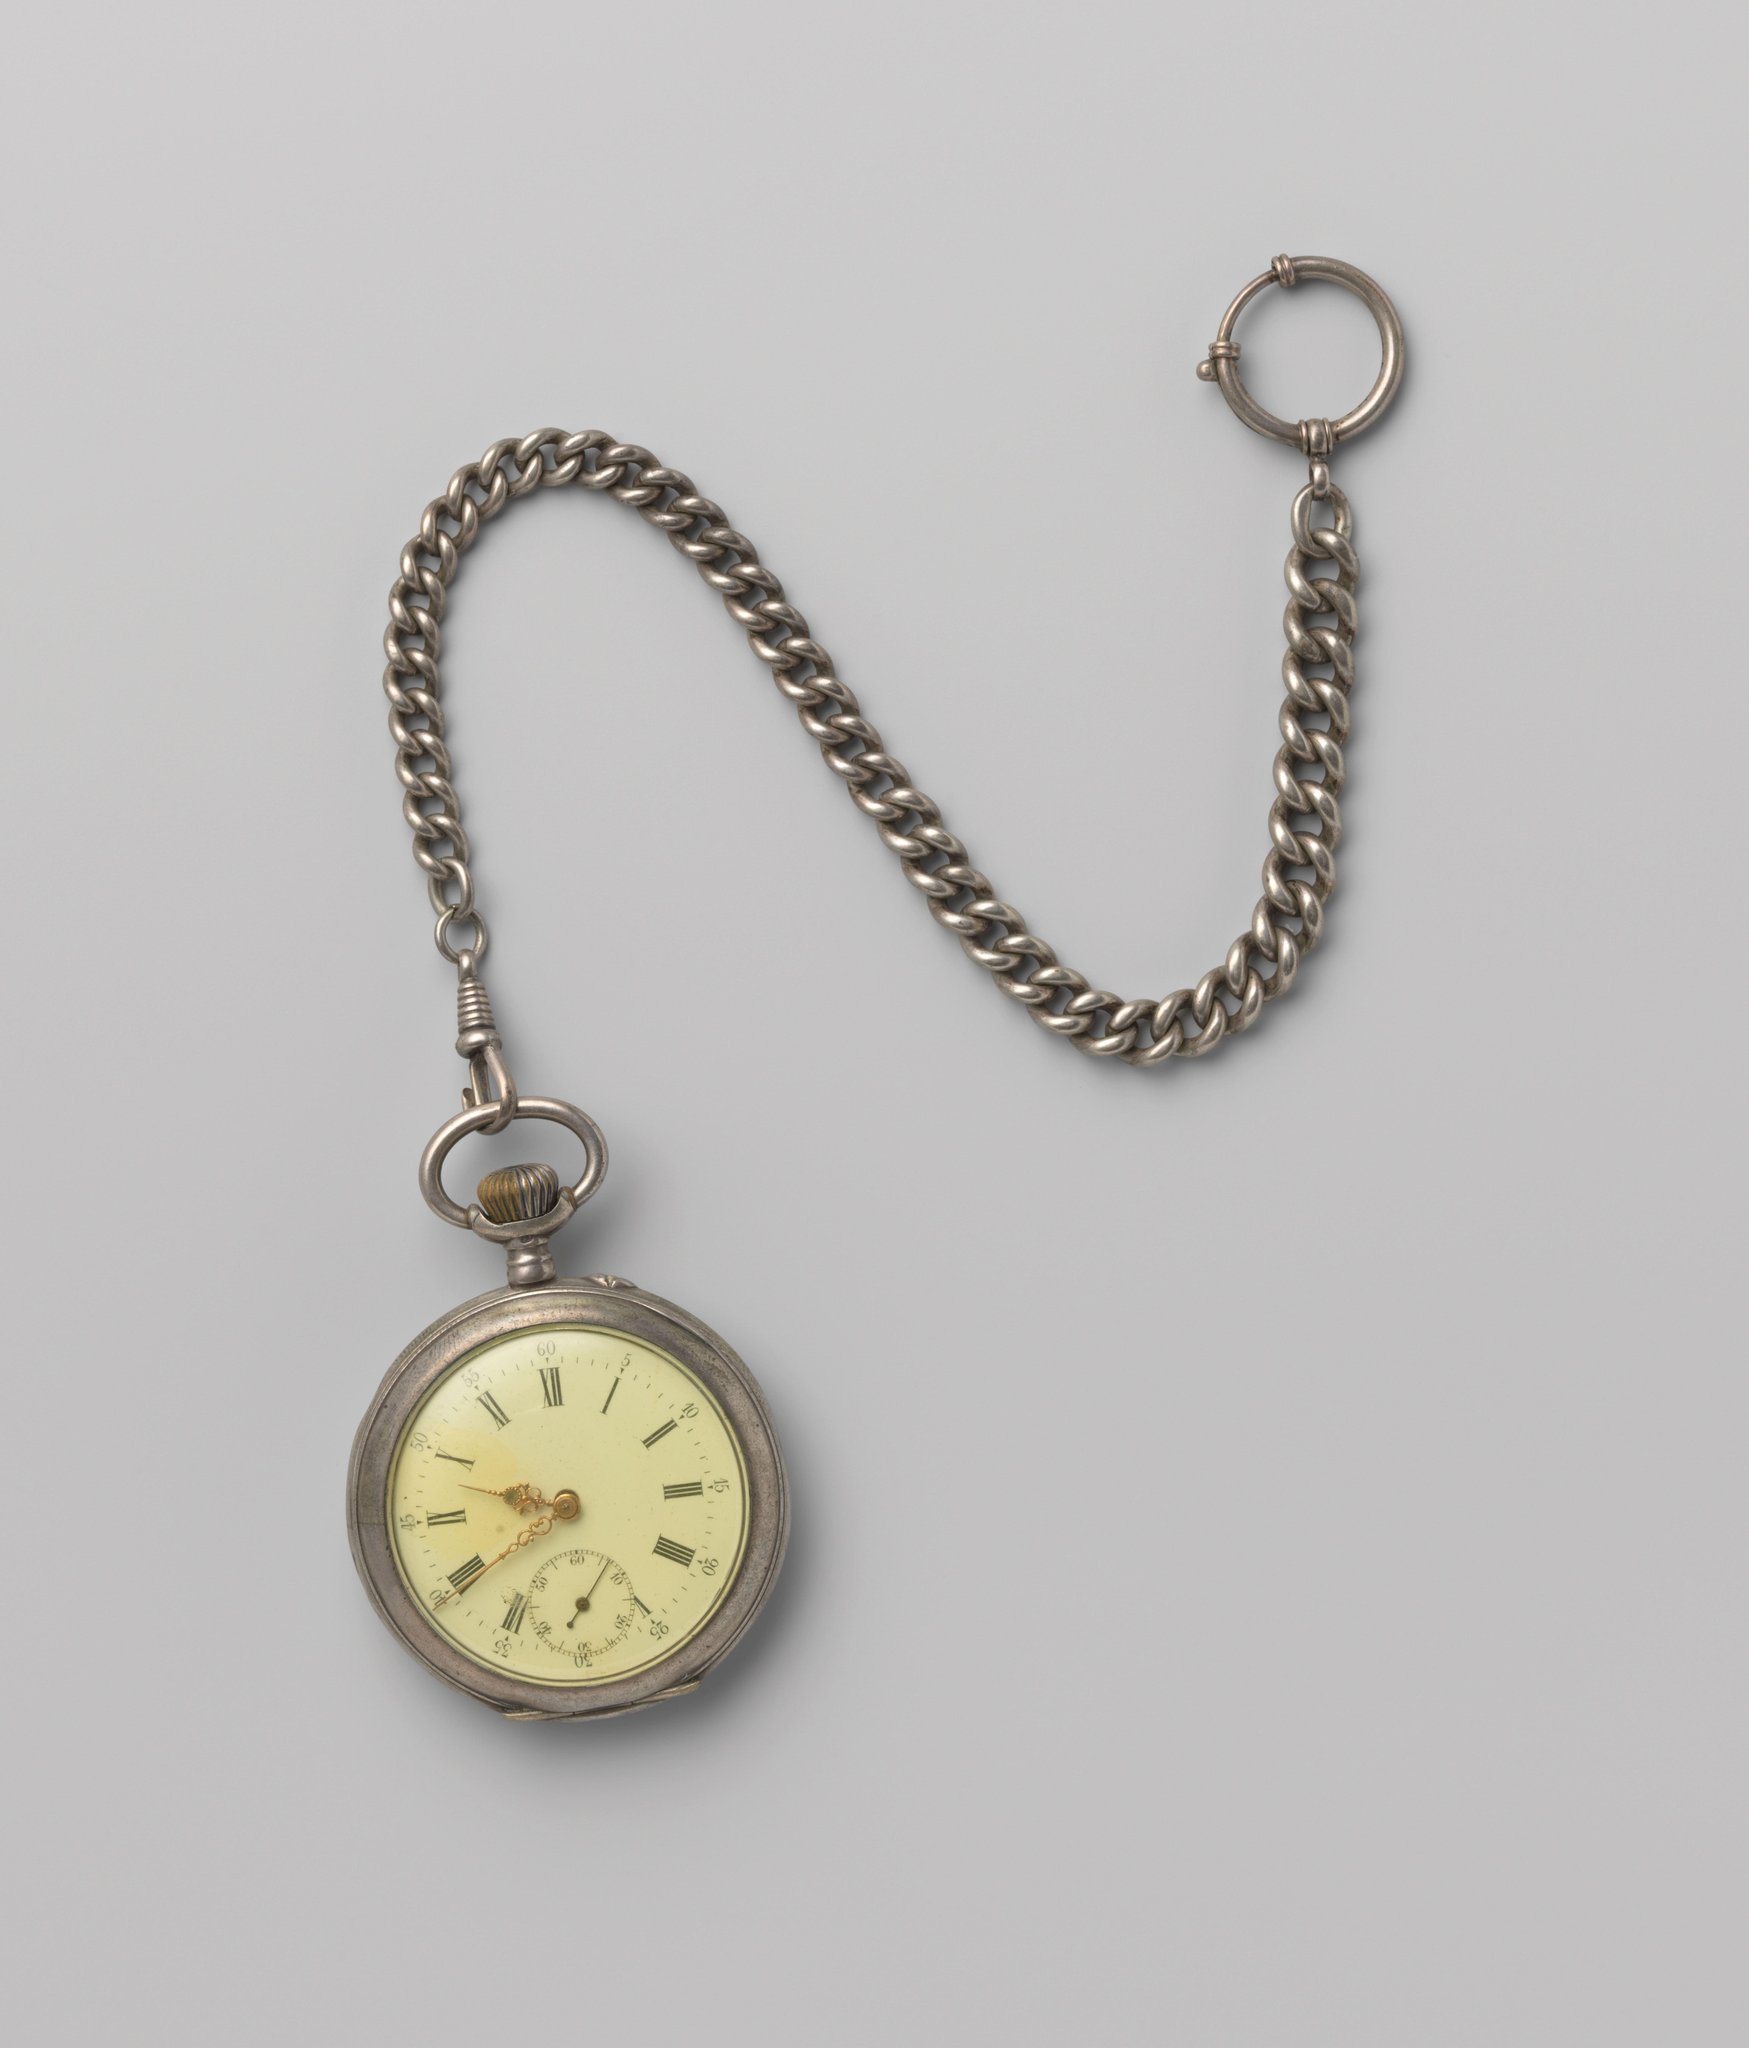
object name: jewellery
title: Herenhorloge van zilver met de letters J.v.D. in cartouche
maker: Anonymous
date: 1913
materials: silver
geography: switzerland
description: Herenhorloge van zilver. De buitenzijde van de achterbodem is versierd met guilloche-werk rondom een cartouche van bladeren. In de cartouce de letters J.v.D. gegraveerd. Met ketting.